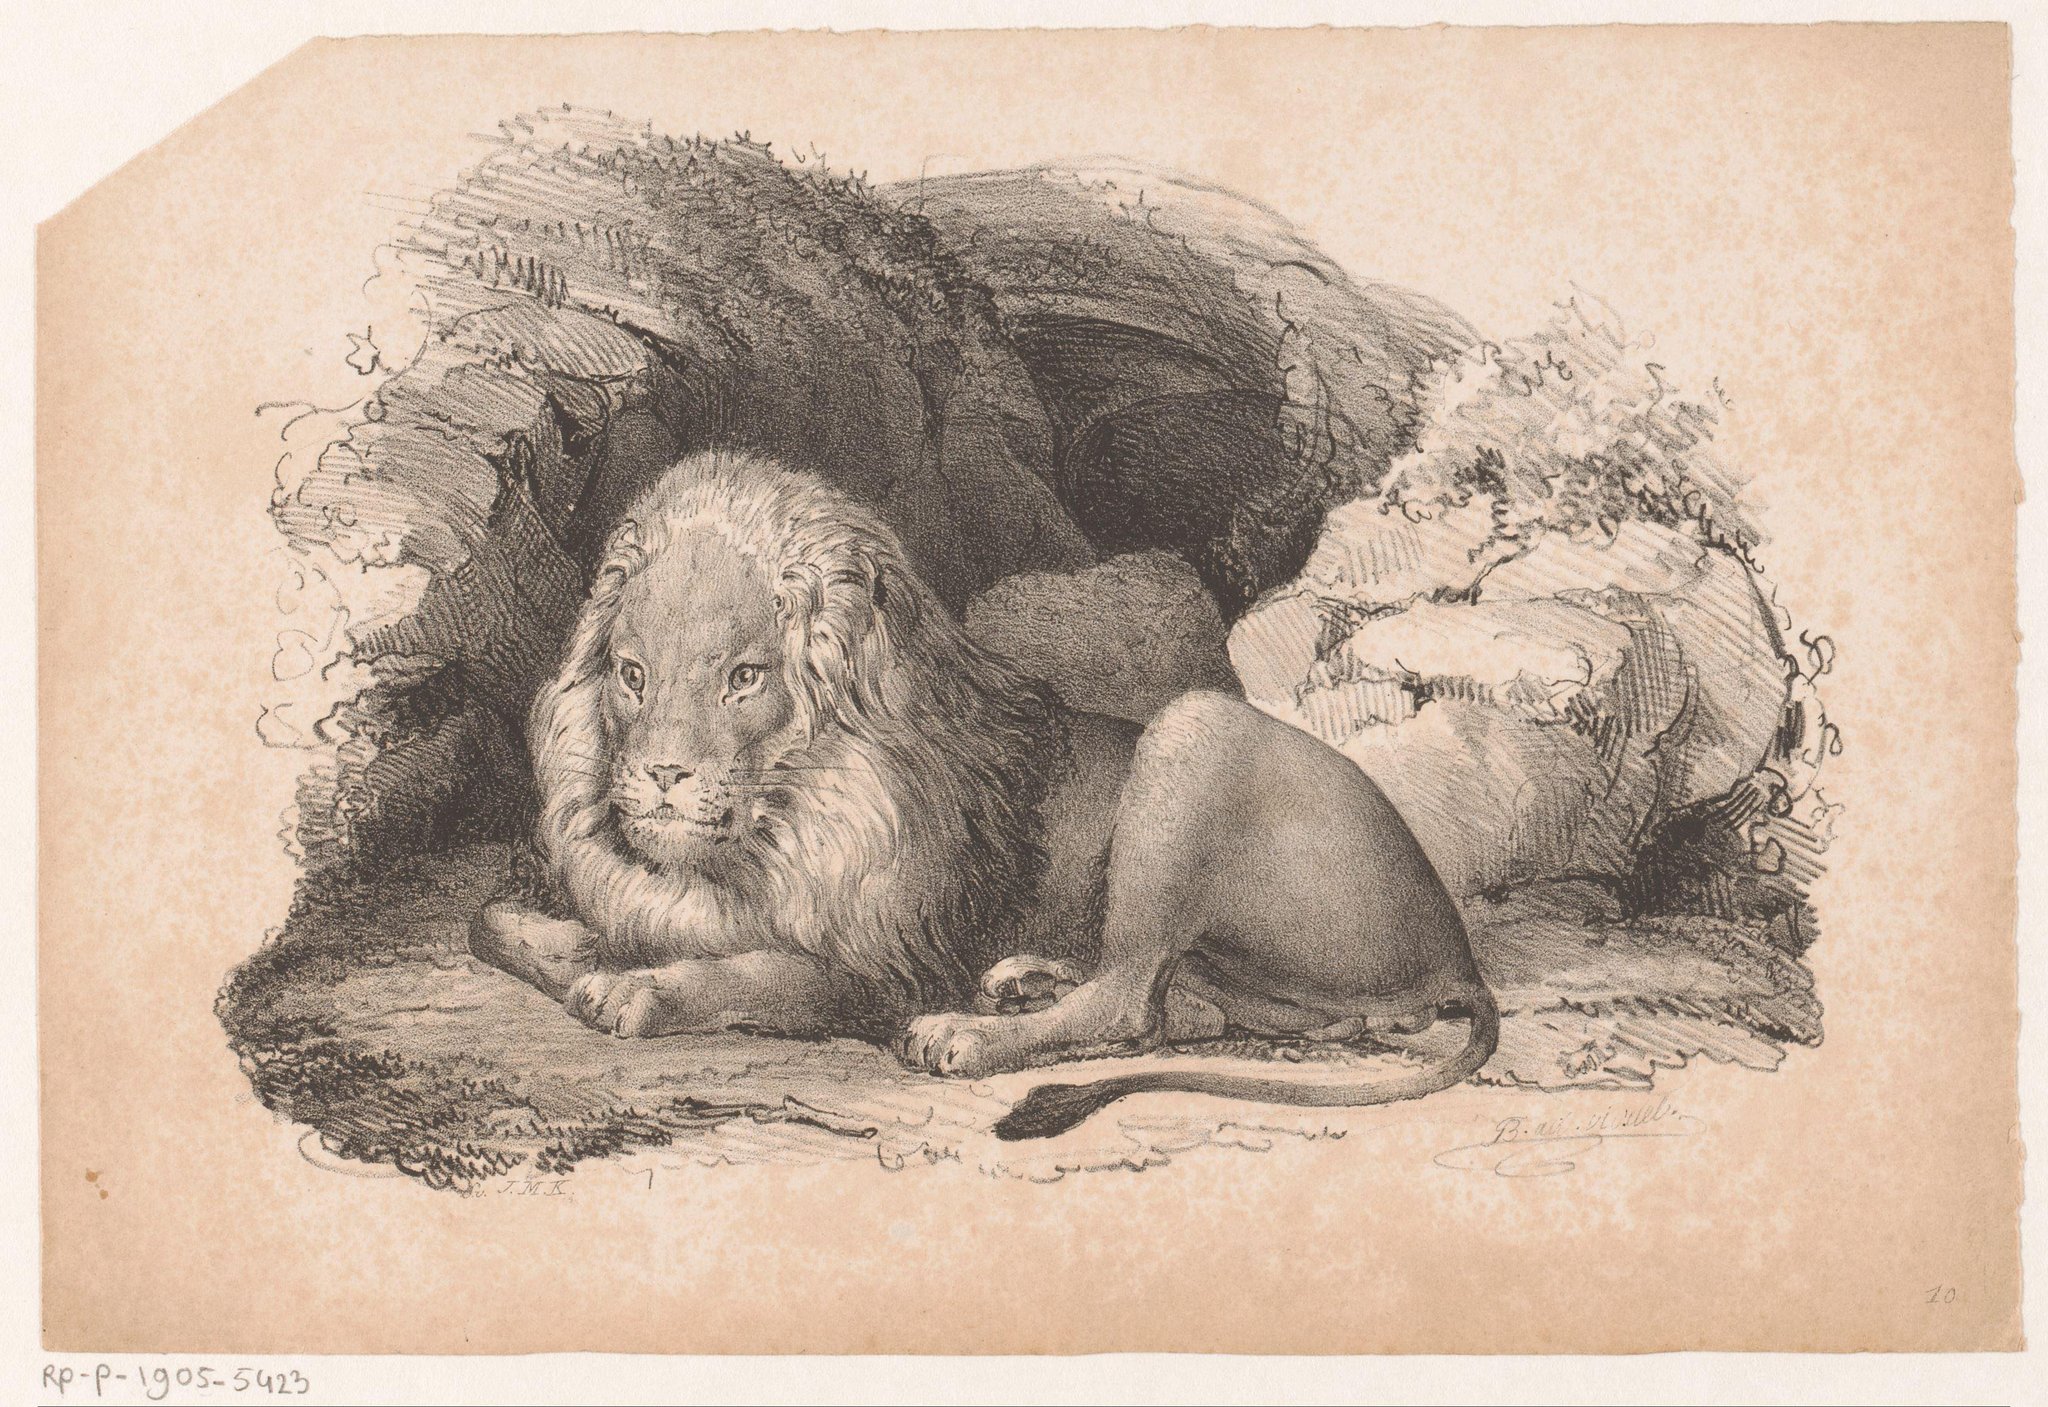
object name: print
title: Liggende leeuw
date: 1842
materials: paper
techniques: lithograph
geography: netherlands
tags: beasts of prey, predatory animals: lion, rocks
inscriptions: collector's mark: Lugt 2228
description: Deze prent verscheen in: Schlegel, H. De Diergaarde en het Museum van het genootschap Natura Artis Magistra te Amsterdam. Amsterdam, M. Westerman & Zoon, 1842, p. 72.